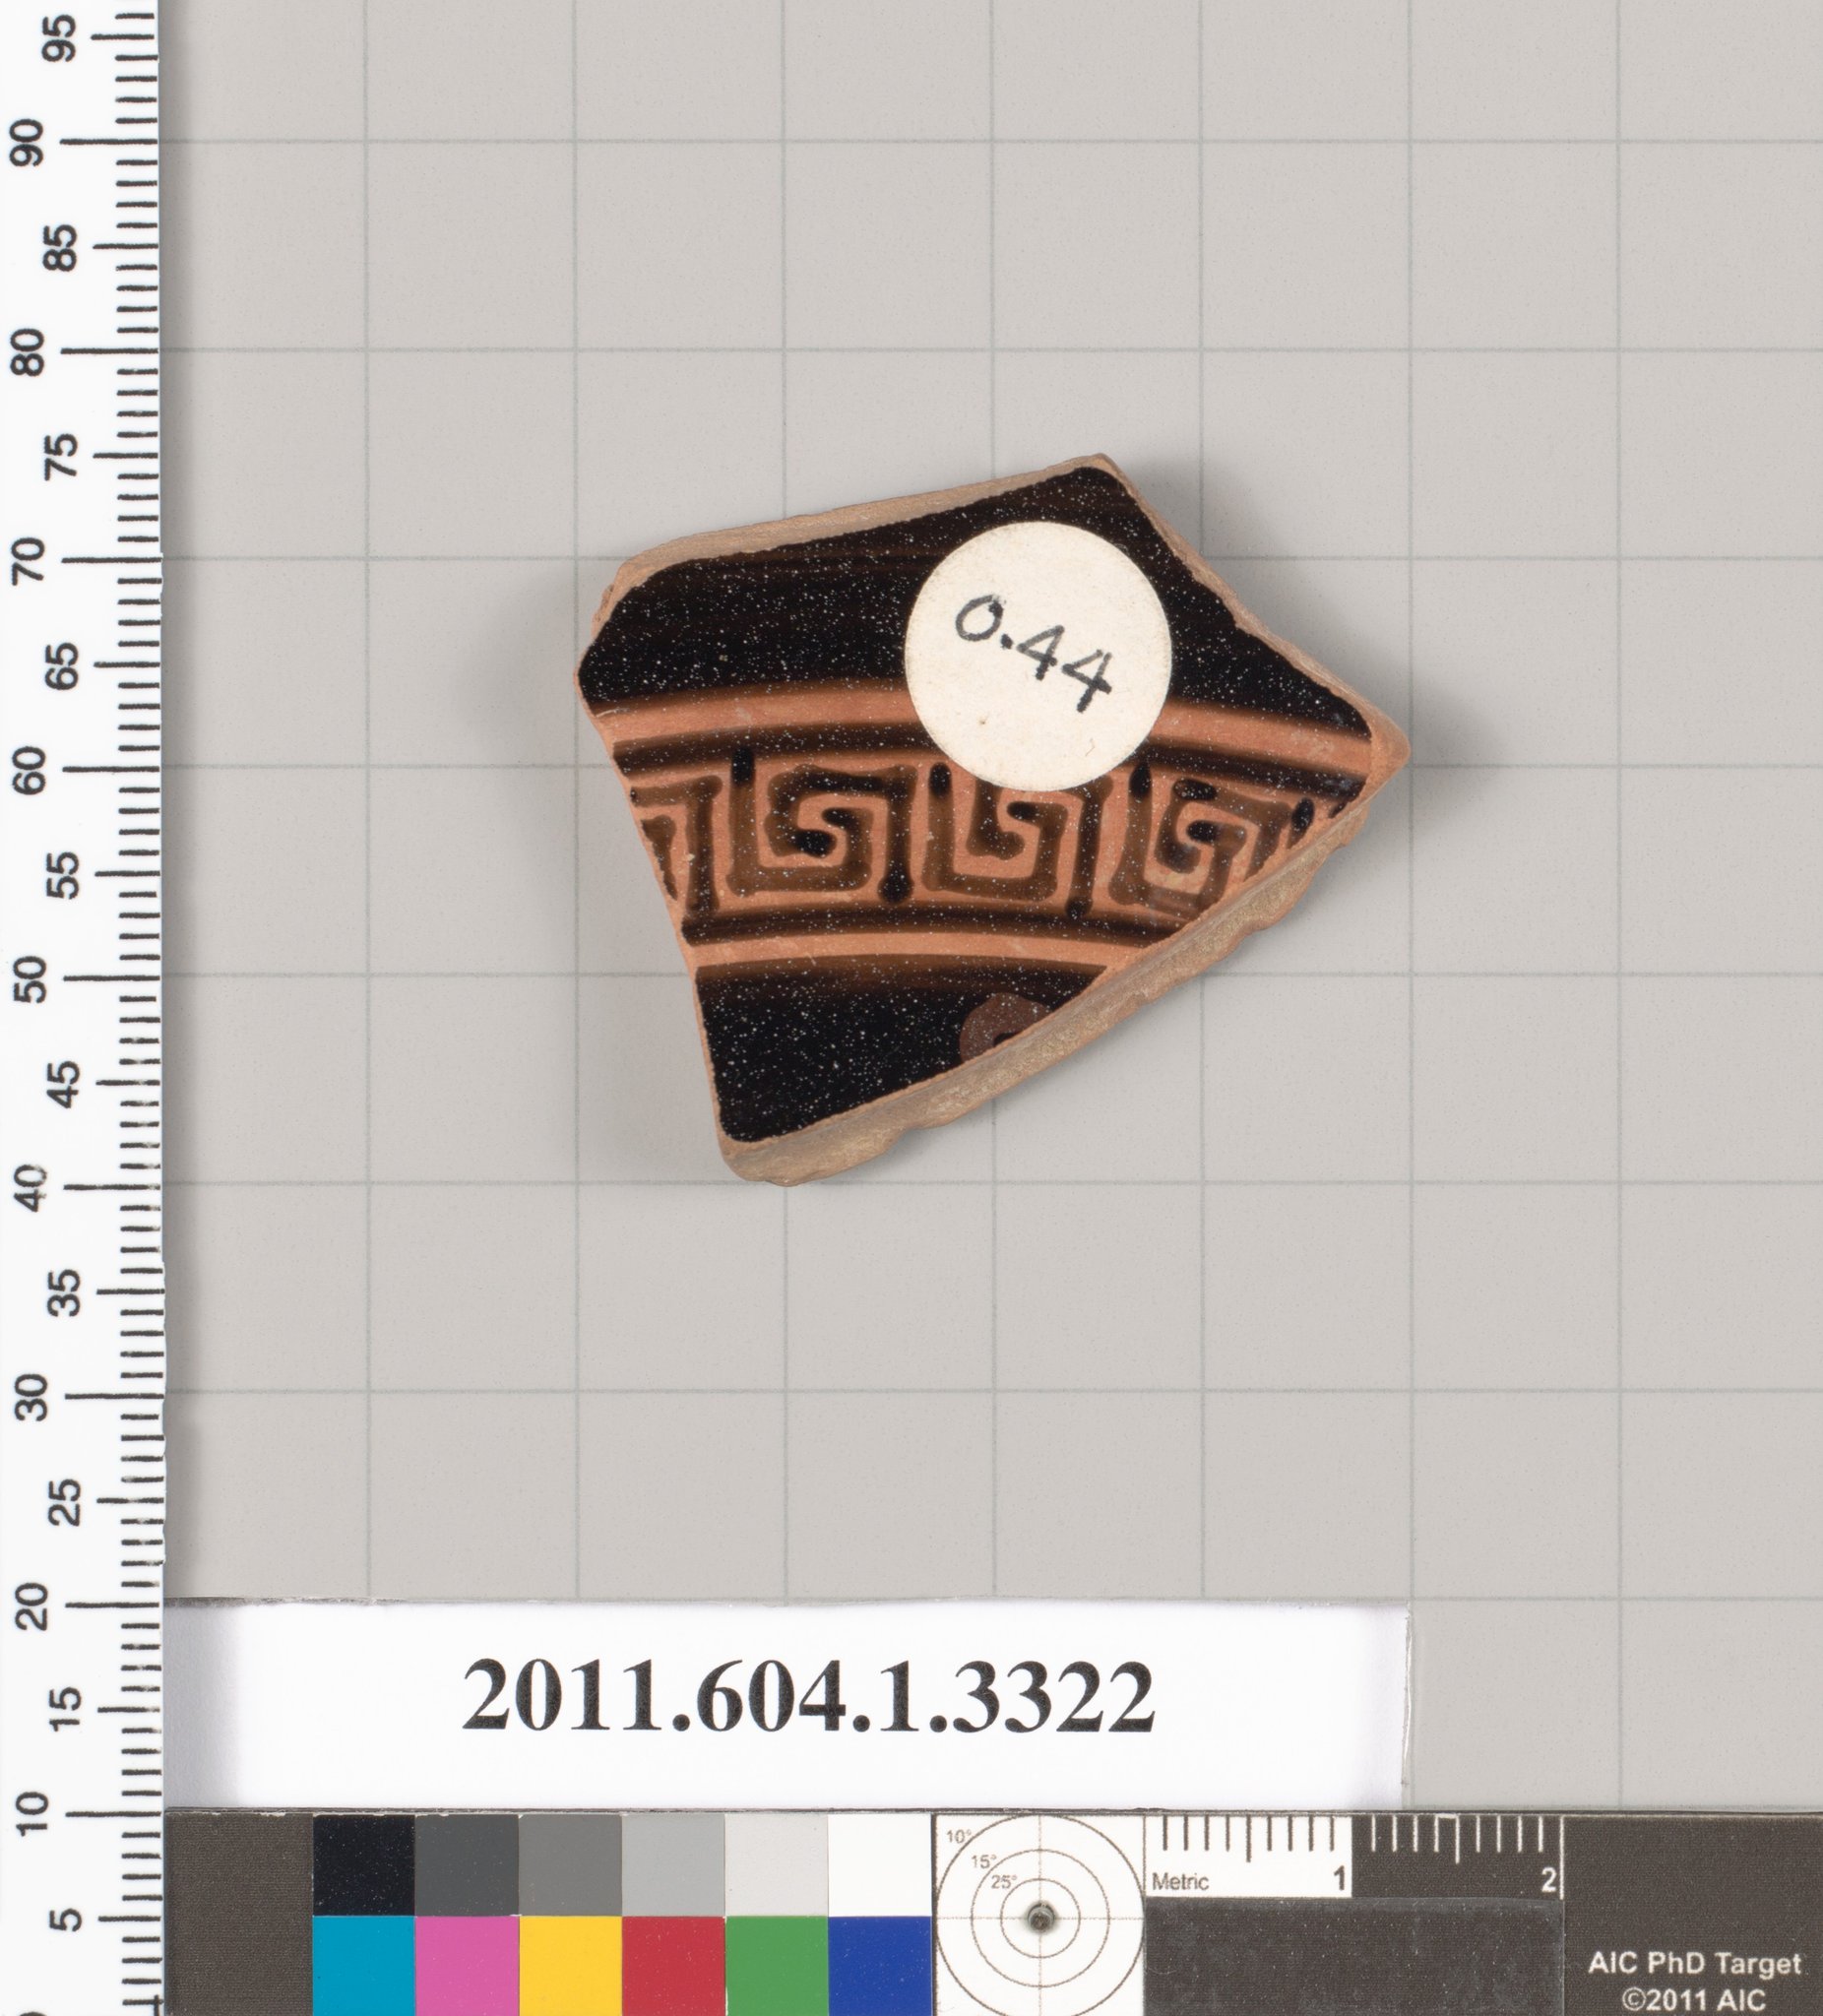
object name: kylix fragment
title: Terracotta fragment of a kylix (drinking cup)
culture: greek, attic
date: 500-470 BCE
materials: terracotta